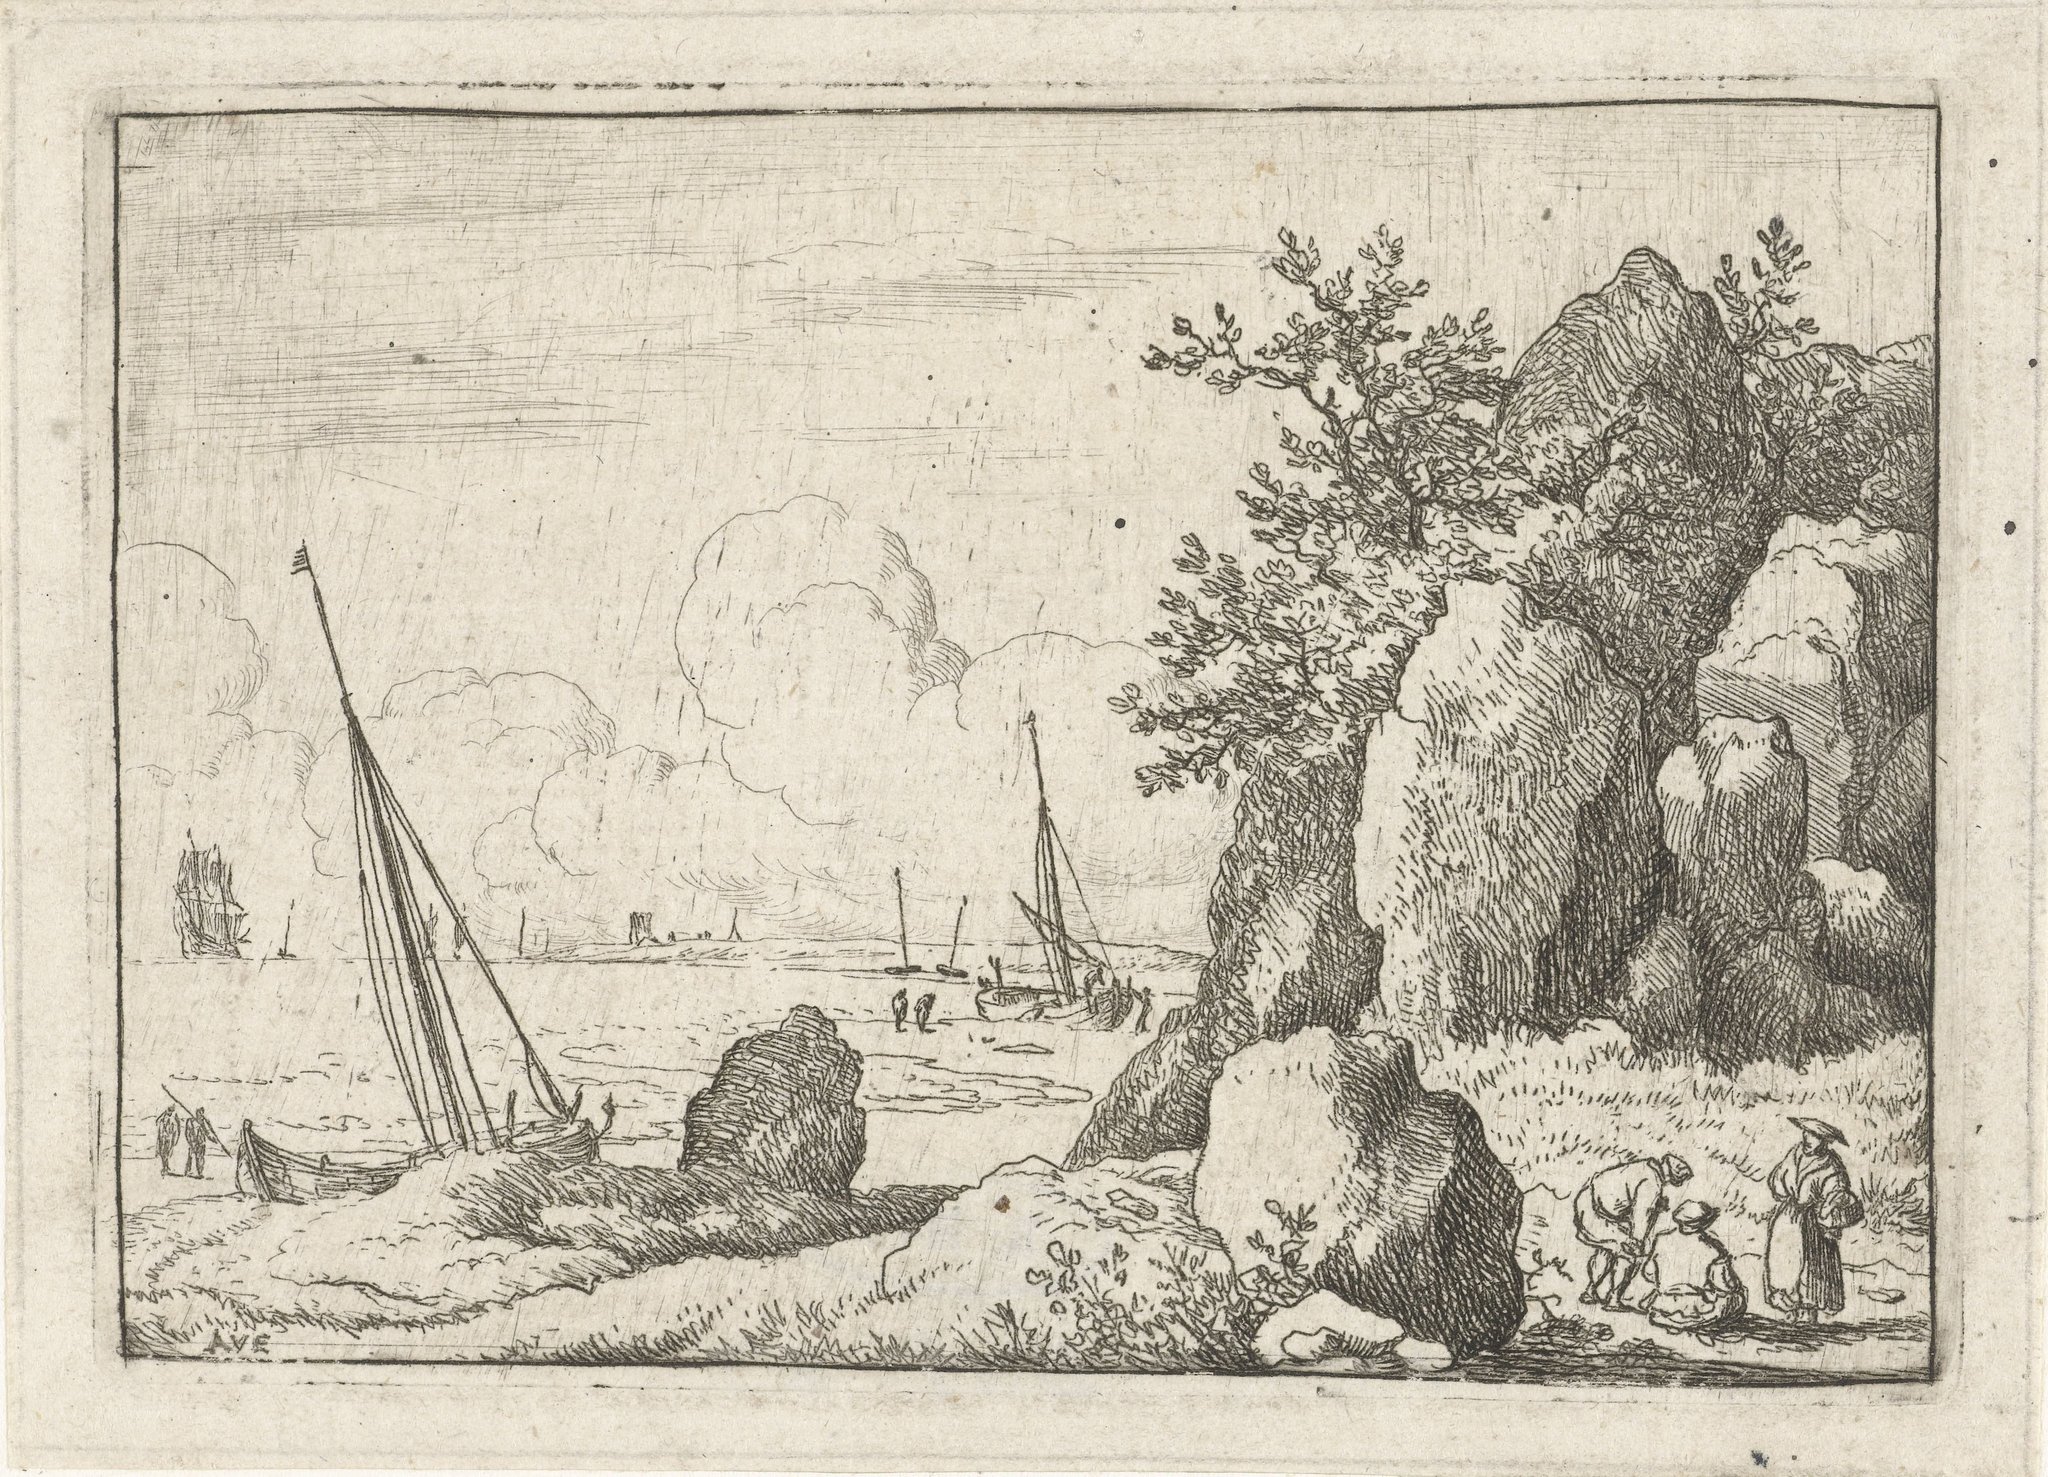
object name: print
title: Zeegezicht met zeilschepen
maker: allaert van everdingen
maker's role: draughtsman, painter, print maker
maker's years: 1621-1675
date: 1631-1675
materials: paper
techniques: etching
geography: netherlands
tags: sea (seascape) (+ landscape with figures, staffage)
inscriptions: collector's mark: Lugt 2228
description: Landschap met rotspartij en zeegezicht met enkele zeilschepen. Op het land, naast een rots, zijn drie personen afgebeeld.